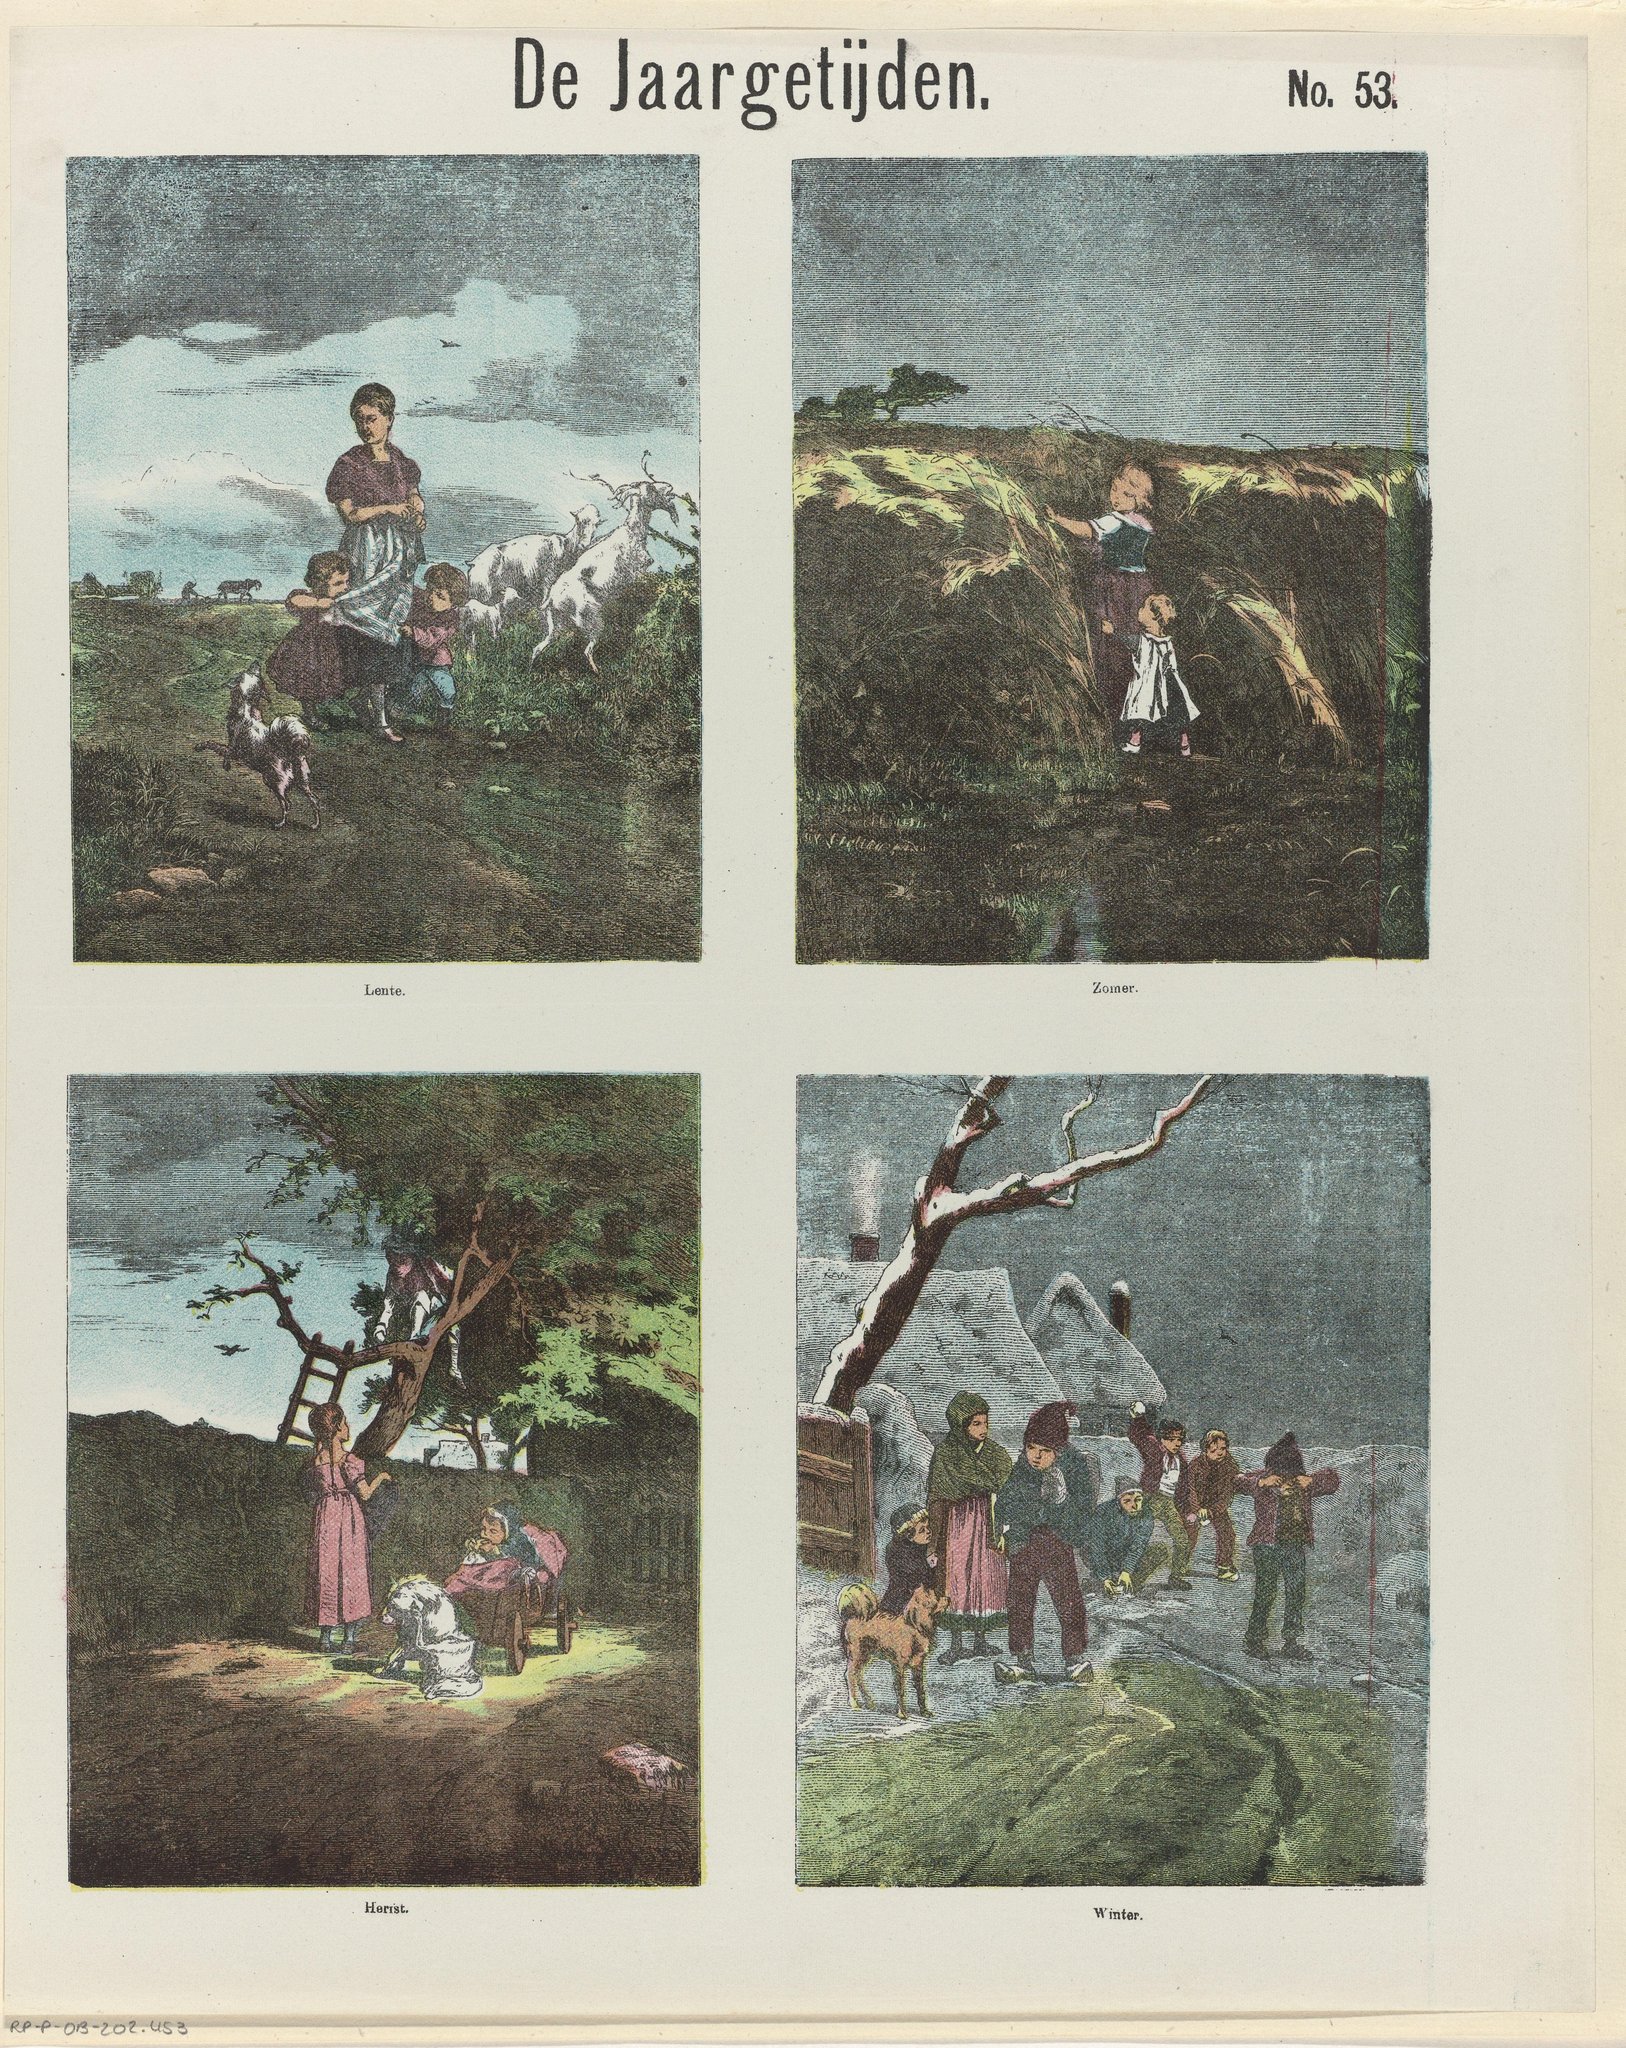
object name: print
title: De jaargetijden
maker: Anonymous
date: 1878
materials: paper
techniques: lithograph, letterpress printing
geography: amsterdam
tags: the four seasons of the year ~ human activities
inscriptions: collector's mark: Lugt 2760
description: Blad met 4 voorstellingen van de vier jaargetijden. Lente wordt verbeeld met een moeder met twee kinderen en een hond in een weiland, zomer met twee kinderen die zich verstoppen in het gewas, herfst met kinderen die appels plukken en winter met kinderen die sneeuwballen gooien. Onder elke afbeelding een onderschrift. Genummerd rechtsboven: No. 53.